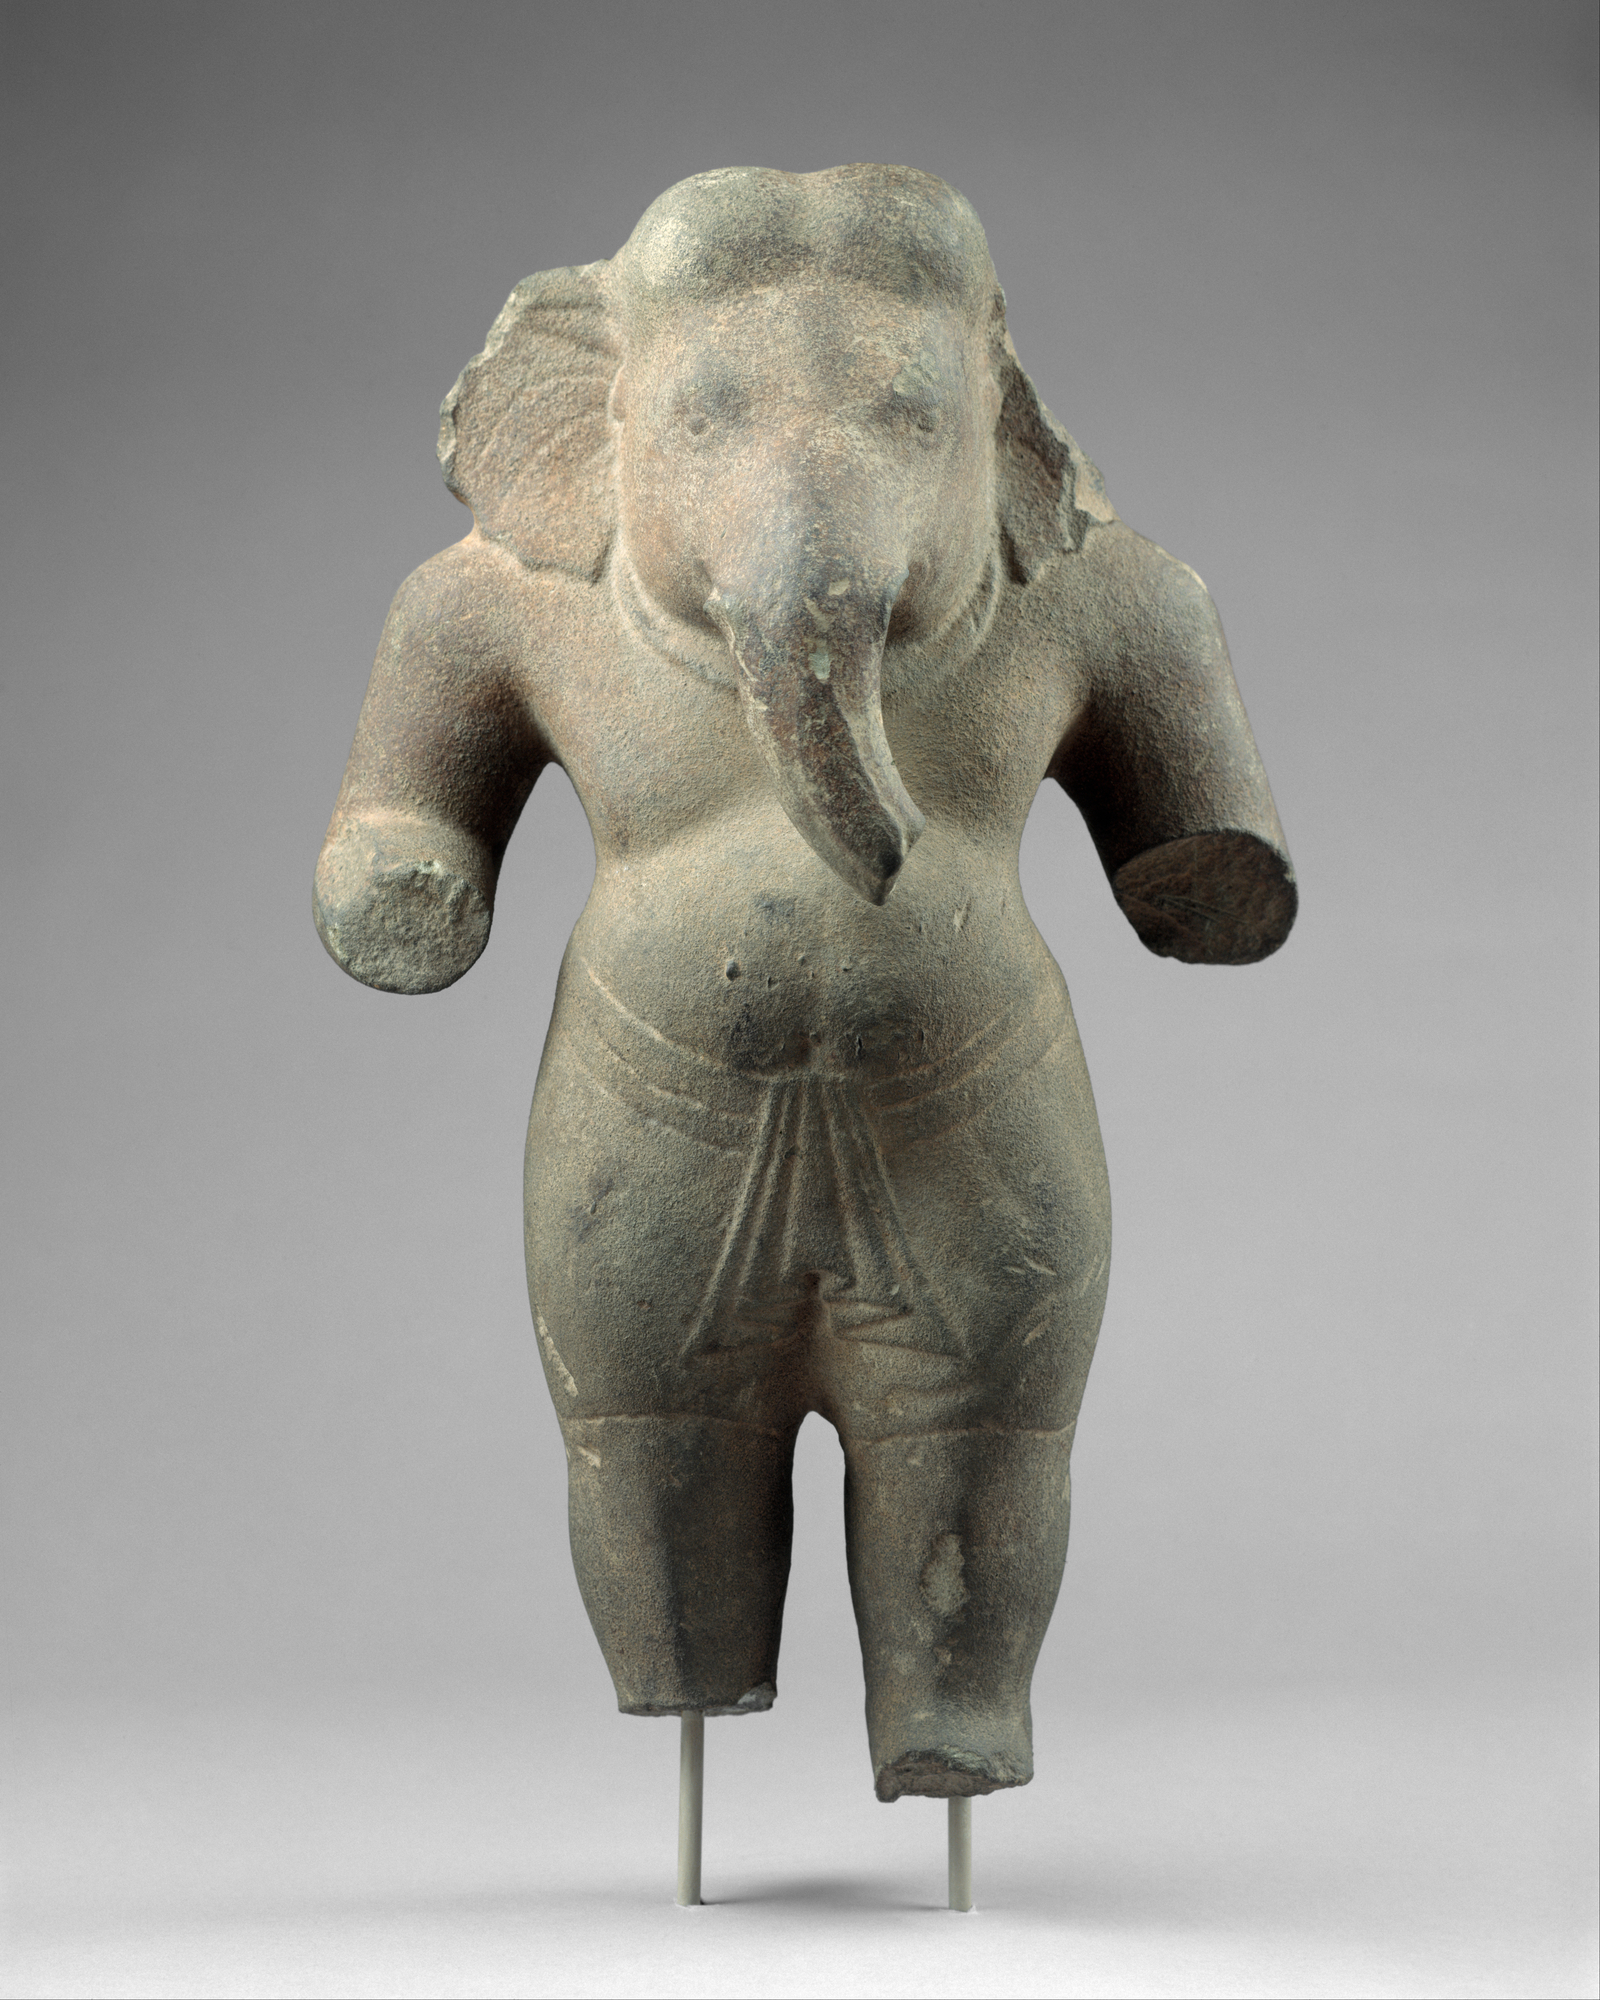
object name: figure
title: Standing Ganesha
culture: cambodian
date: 651-700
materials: stone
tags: elephants,ganesha